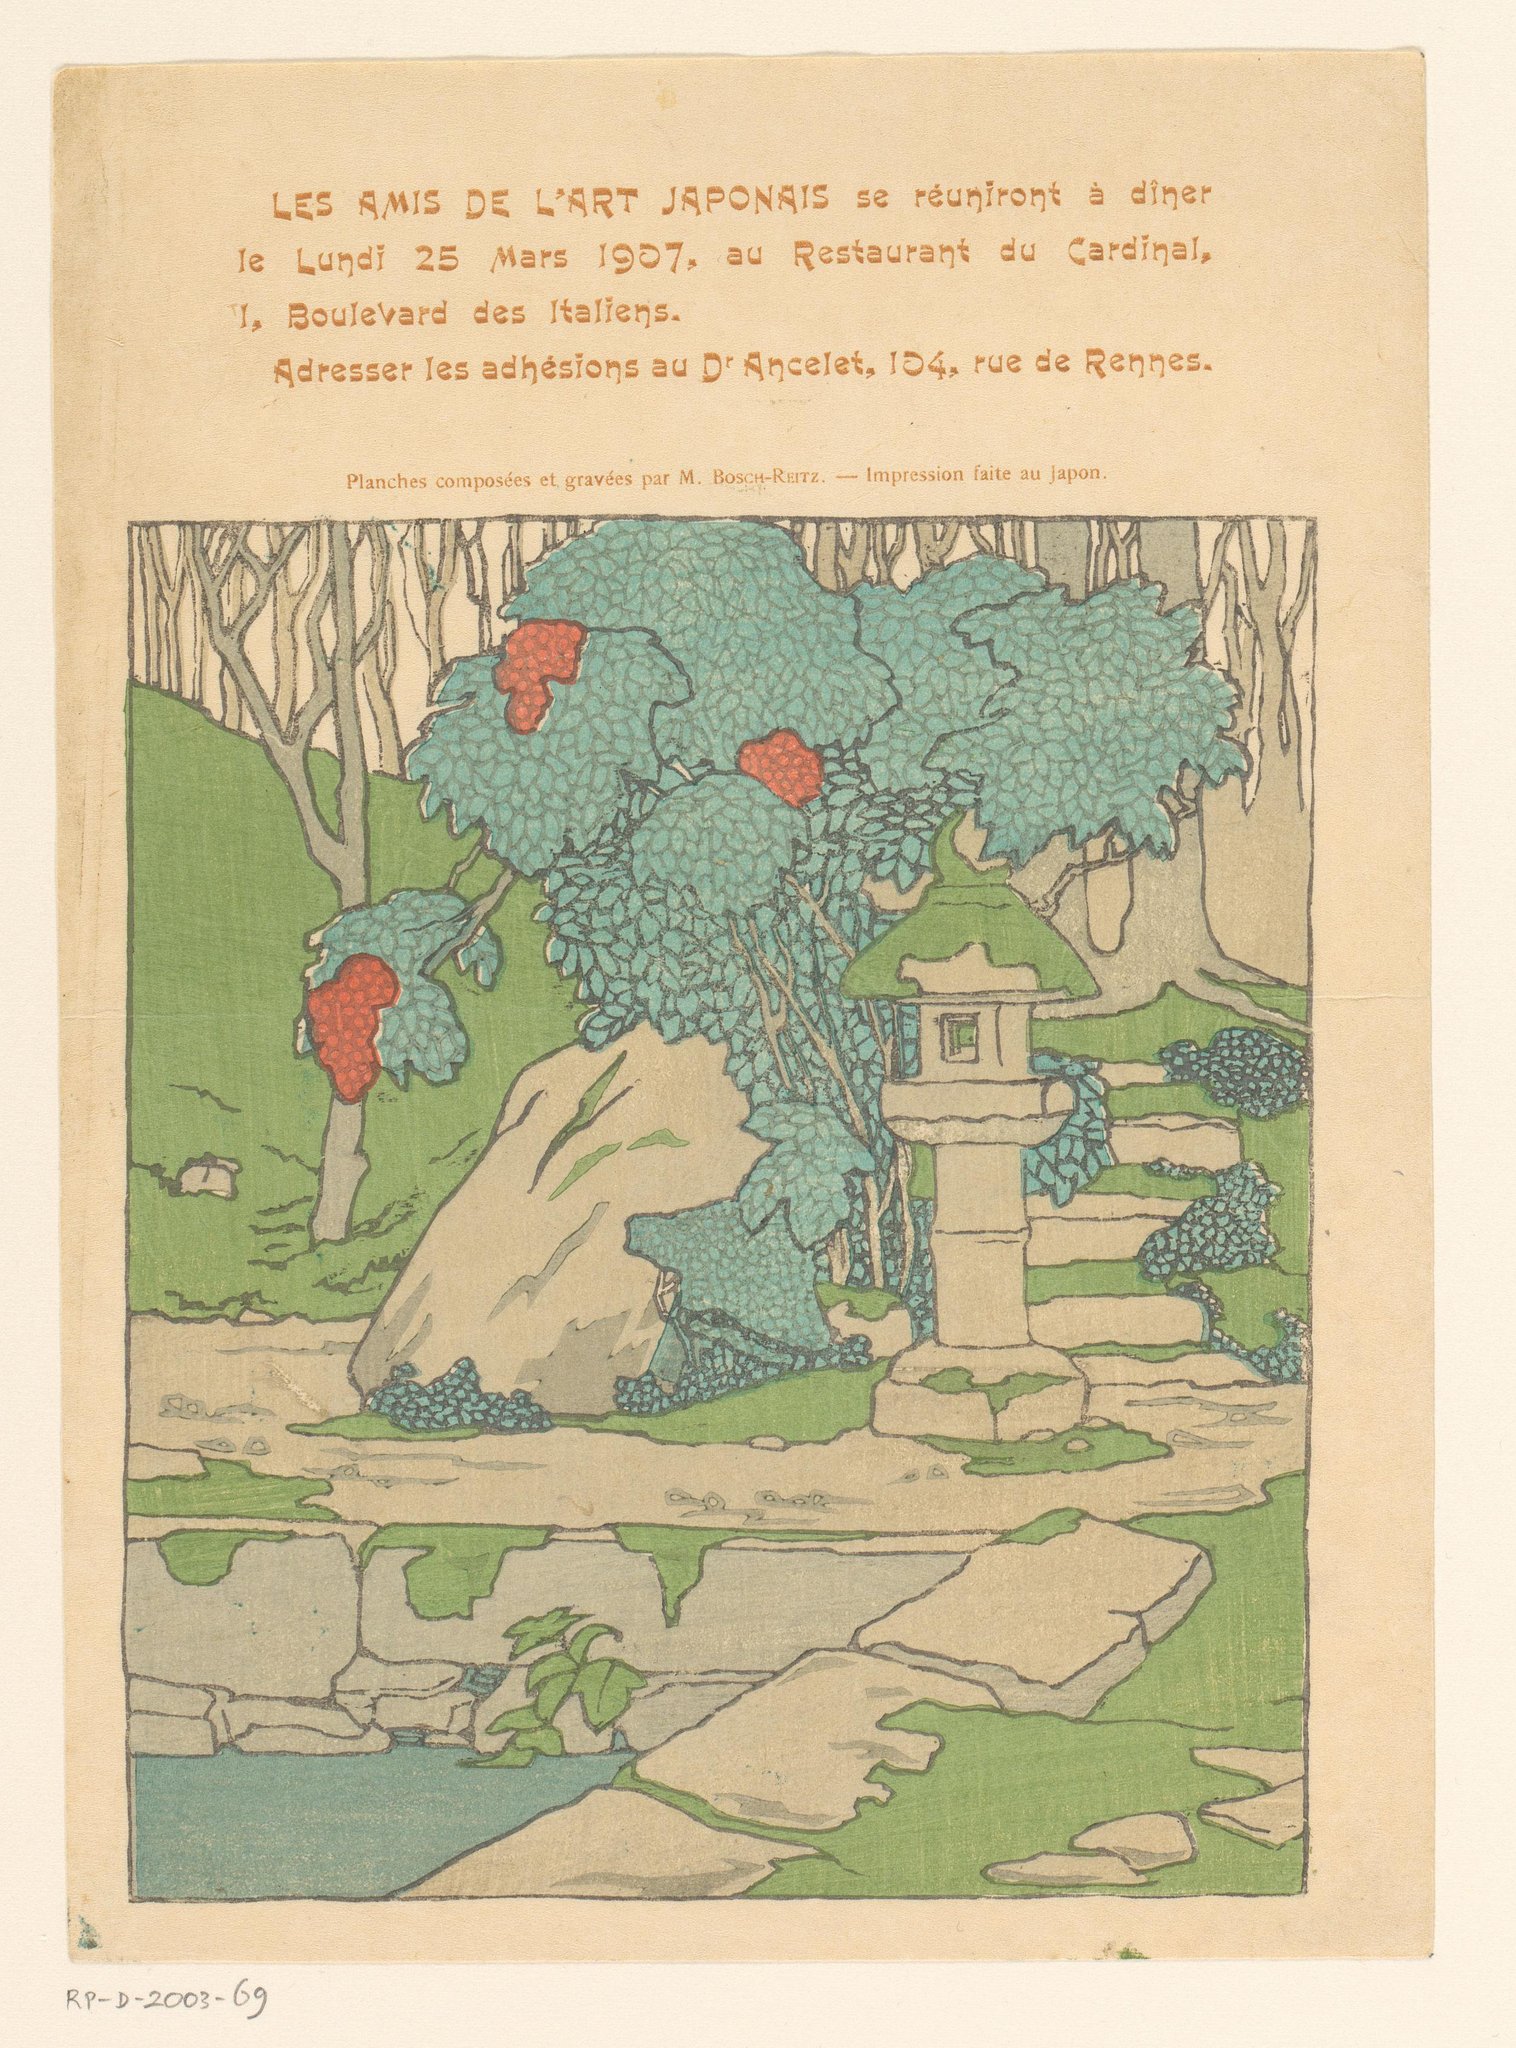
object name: print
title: Uitnodiging voor een diner van Les Amis de l'Art Japonais, 25 maart 1907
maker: minca bosch reitz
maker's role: sculptor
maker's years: 1870-1950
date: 1903-1907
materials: paper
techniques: woodcut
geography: netherlands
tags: forest, wood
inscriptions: collector's mark: Lugt 2228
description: Boslandschap met stenen, bomen en een zuil of altaar rondom een vijver. Uitnodiging voor een diner van Les Amis de l'Art Japonais, 25 maart 1907.